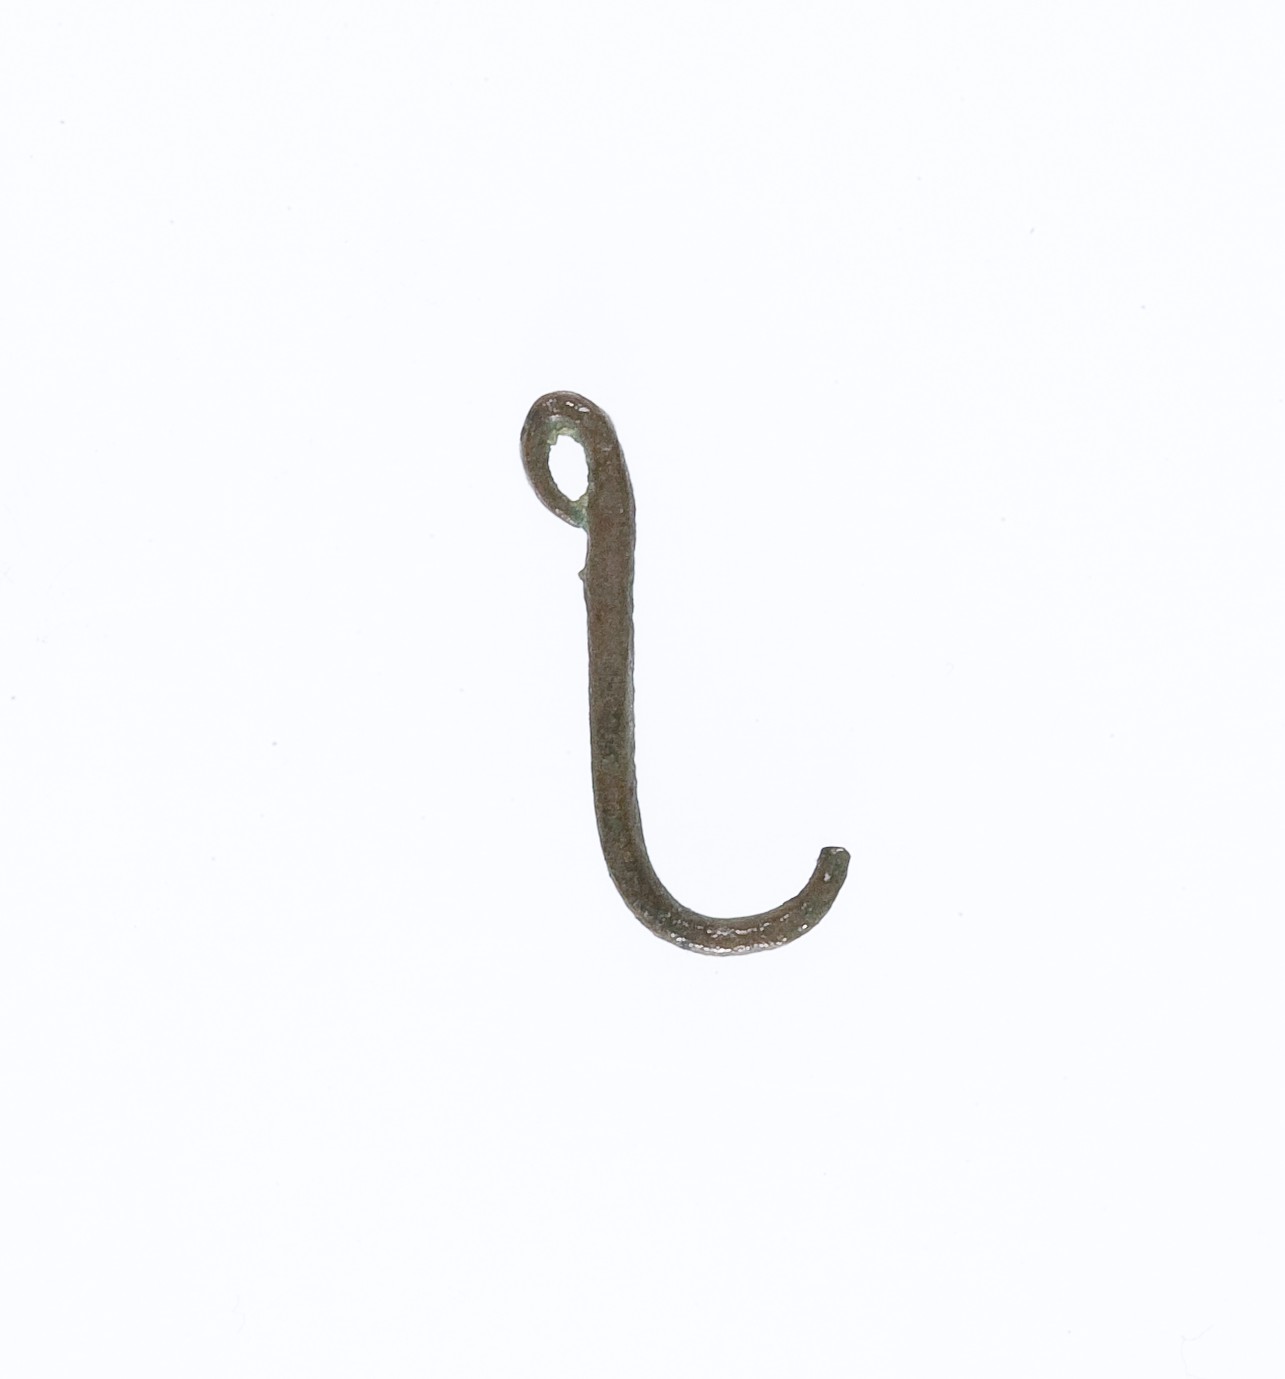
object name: fish hook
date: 1295-1070 BCE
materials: bronze, copper alloy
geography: egypt